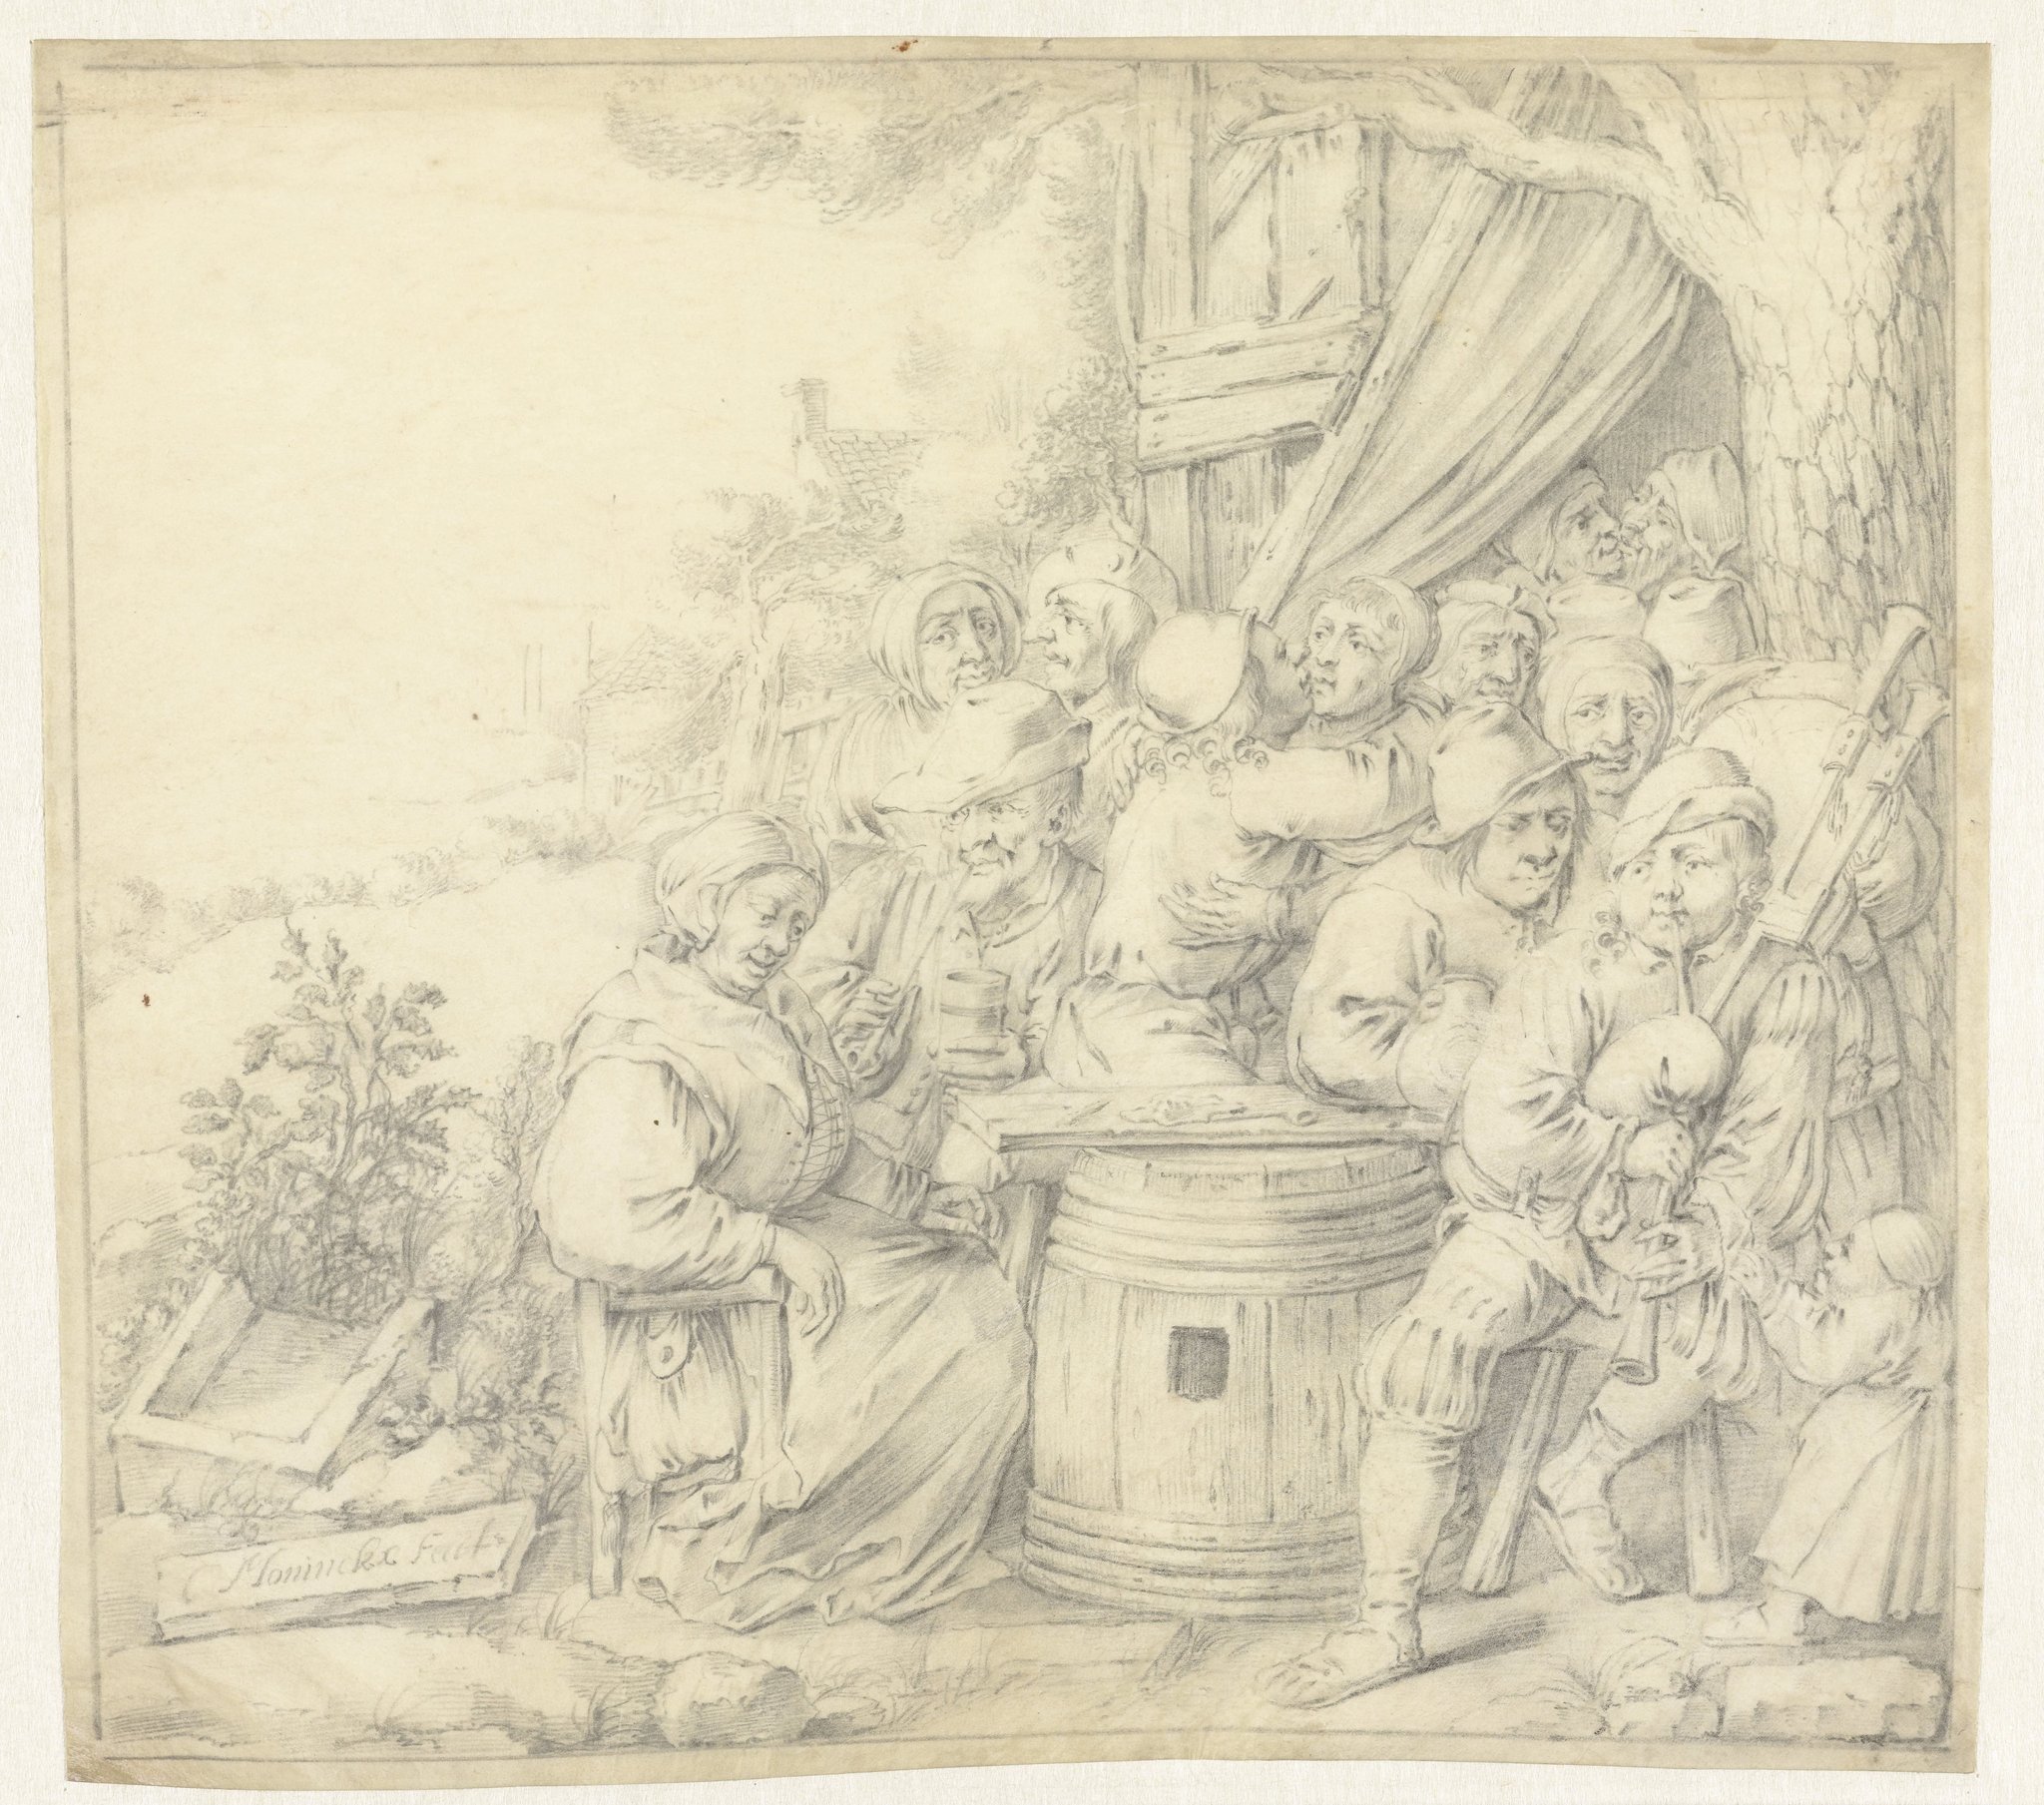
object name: drawing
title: Boerendrinkgelag in de open lucht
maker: cornelis moninckx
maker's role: draughtsman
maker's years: 1623-1666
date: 1633-1666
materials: parchment, pencil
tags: one person playing wind instrument, bagpipe, musette, private festivities, merry company - aa - in the open air, 'fête champêtre'